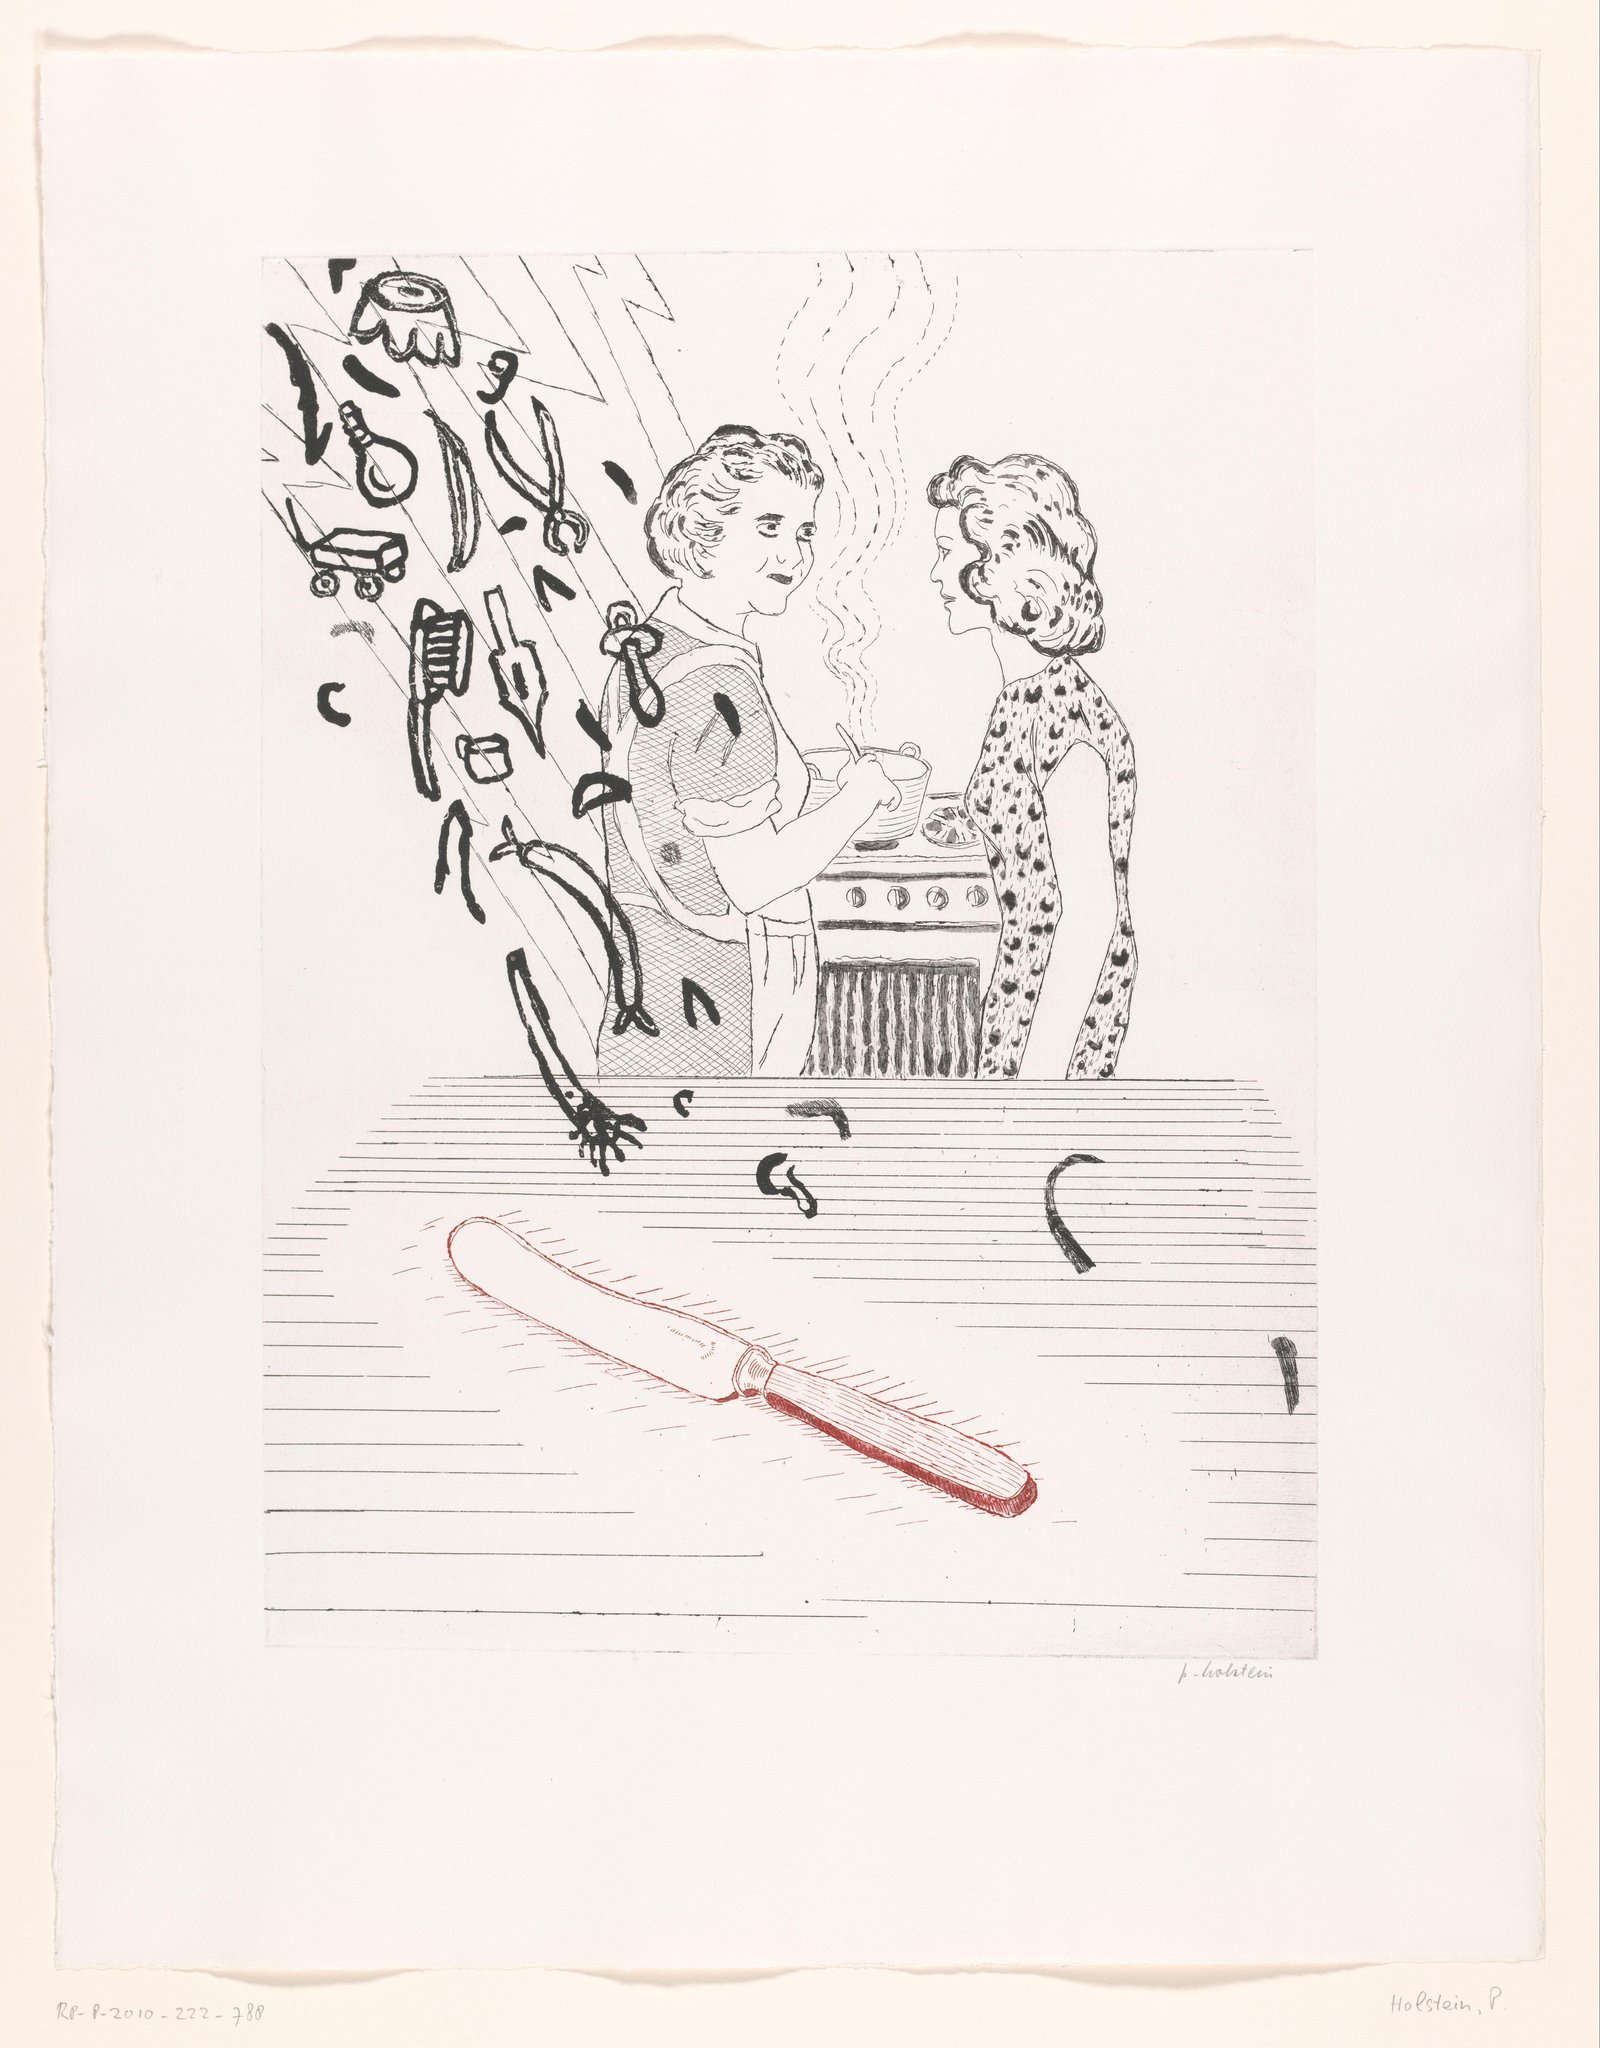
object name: print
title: Het dagelijks leven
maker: pieter holstein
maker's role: draughtsman, painter, print maker, sculptor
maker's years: 1934-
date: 1986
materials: paper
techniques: aquatint, etching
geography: amsterdam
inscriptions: signature: ‘p. holstein’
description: De serietitel is door het museum toegekend bij gebrek aan informatie over een originele serietitel.